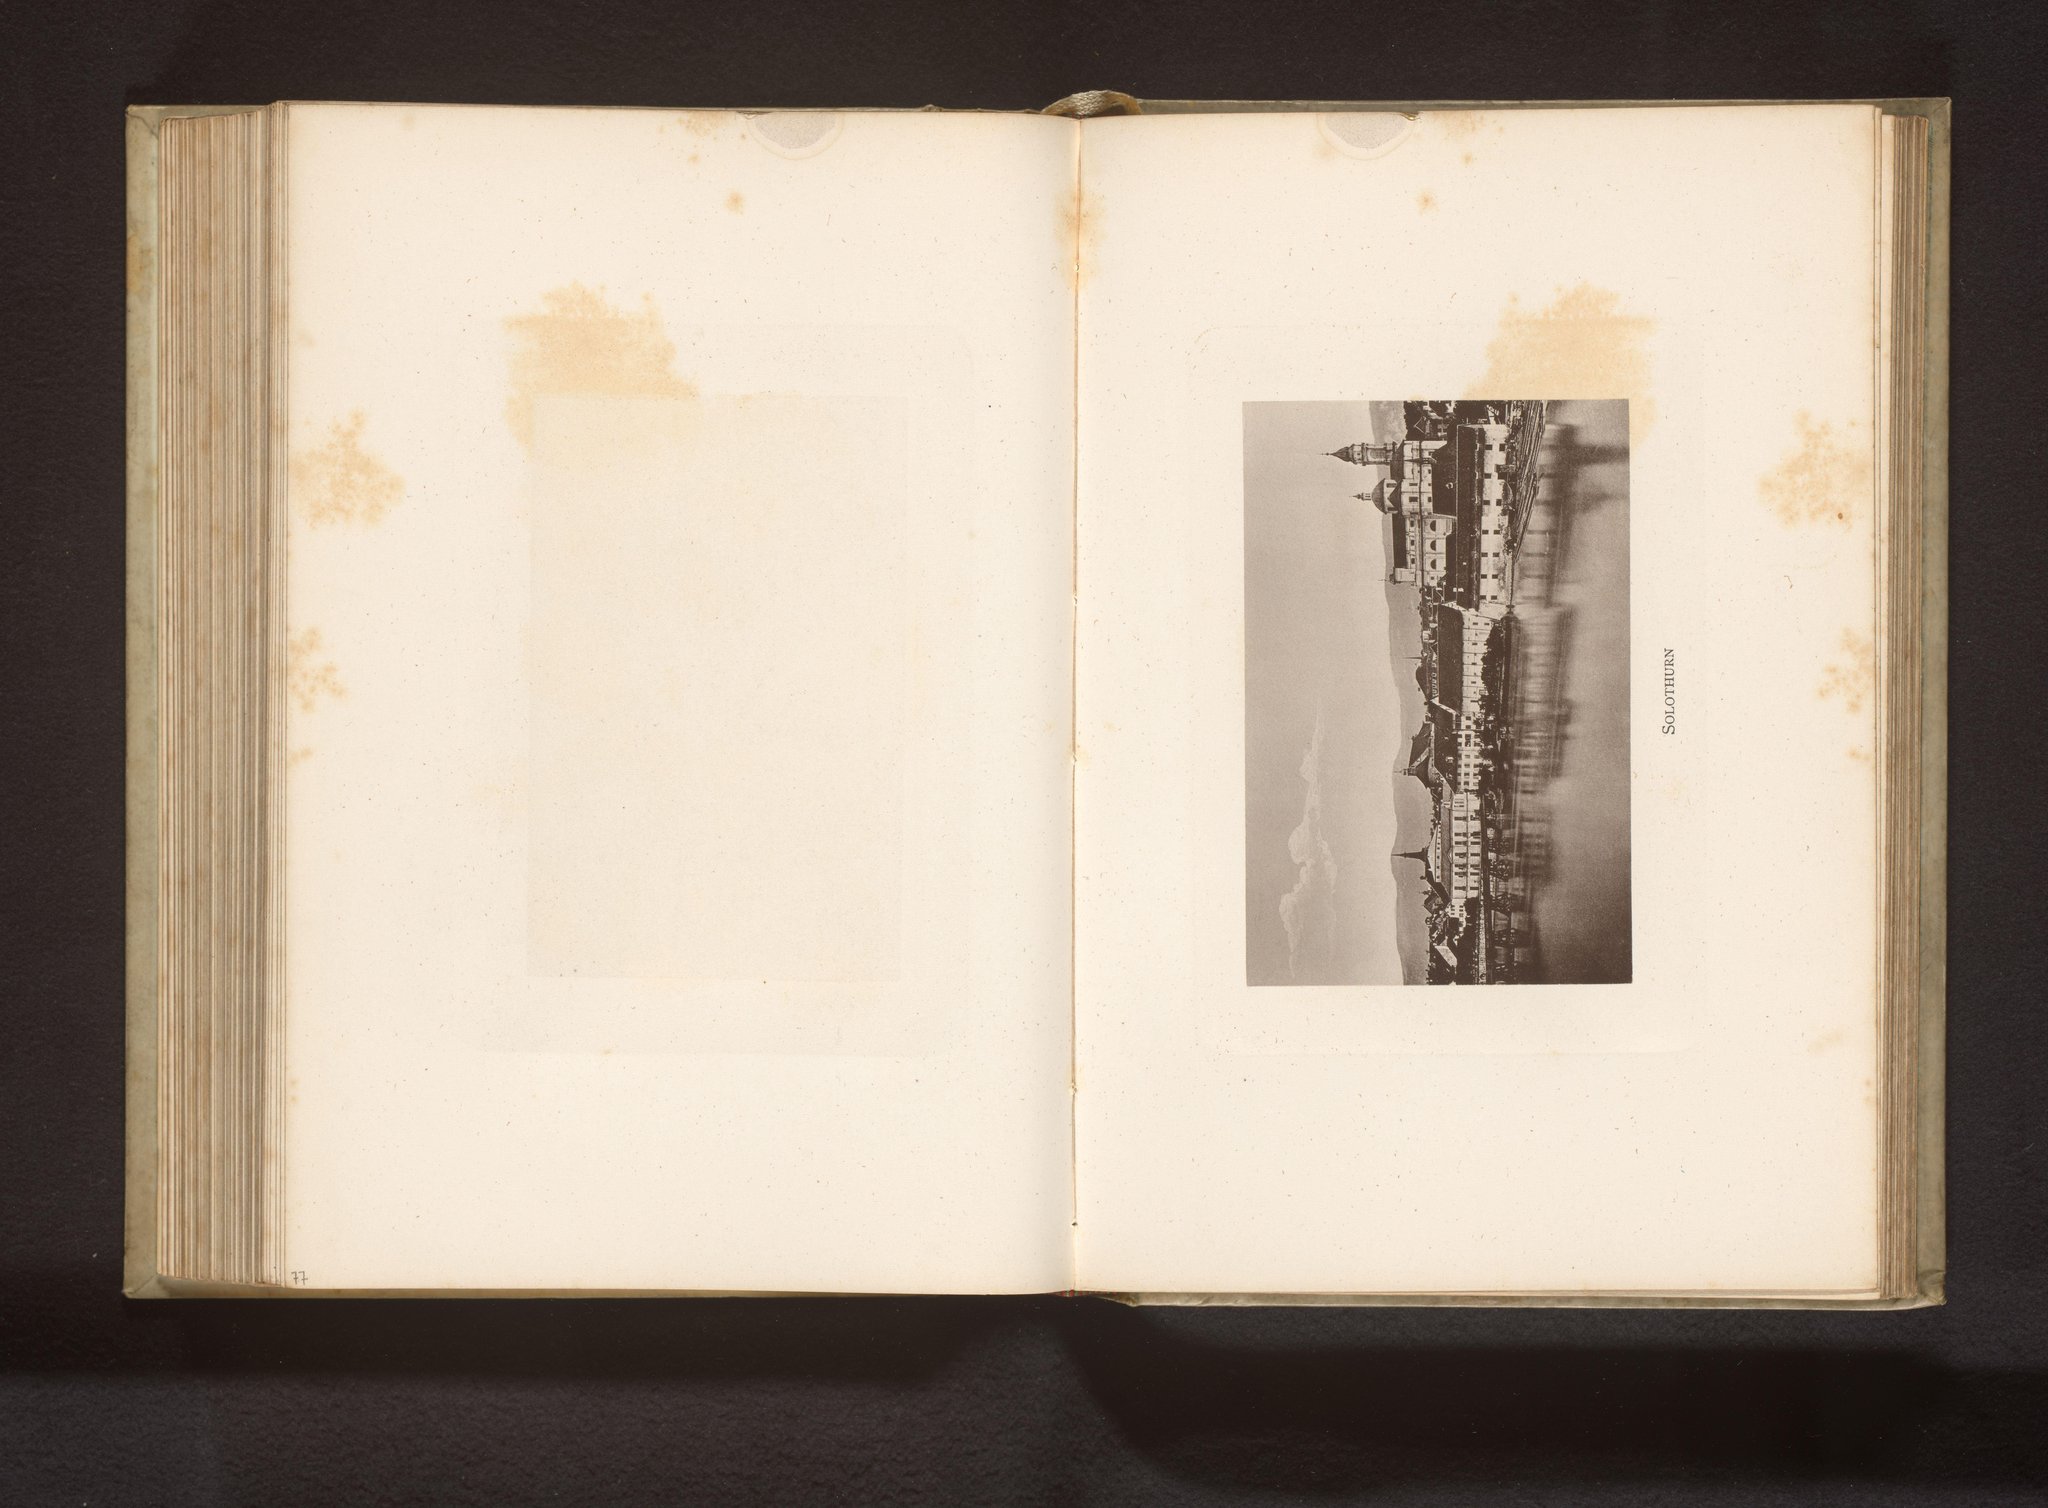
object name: photomechanical print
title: Solothurn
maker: Anonymous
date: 1874-1884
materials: paper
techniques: photograph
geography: solothurn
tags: city-view, and landscape with man-made constructions, river